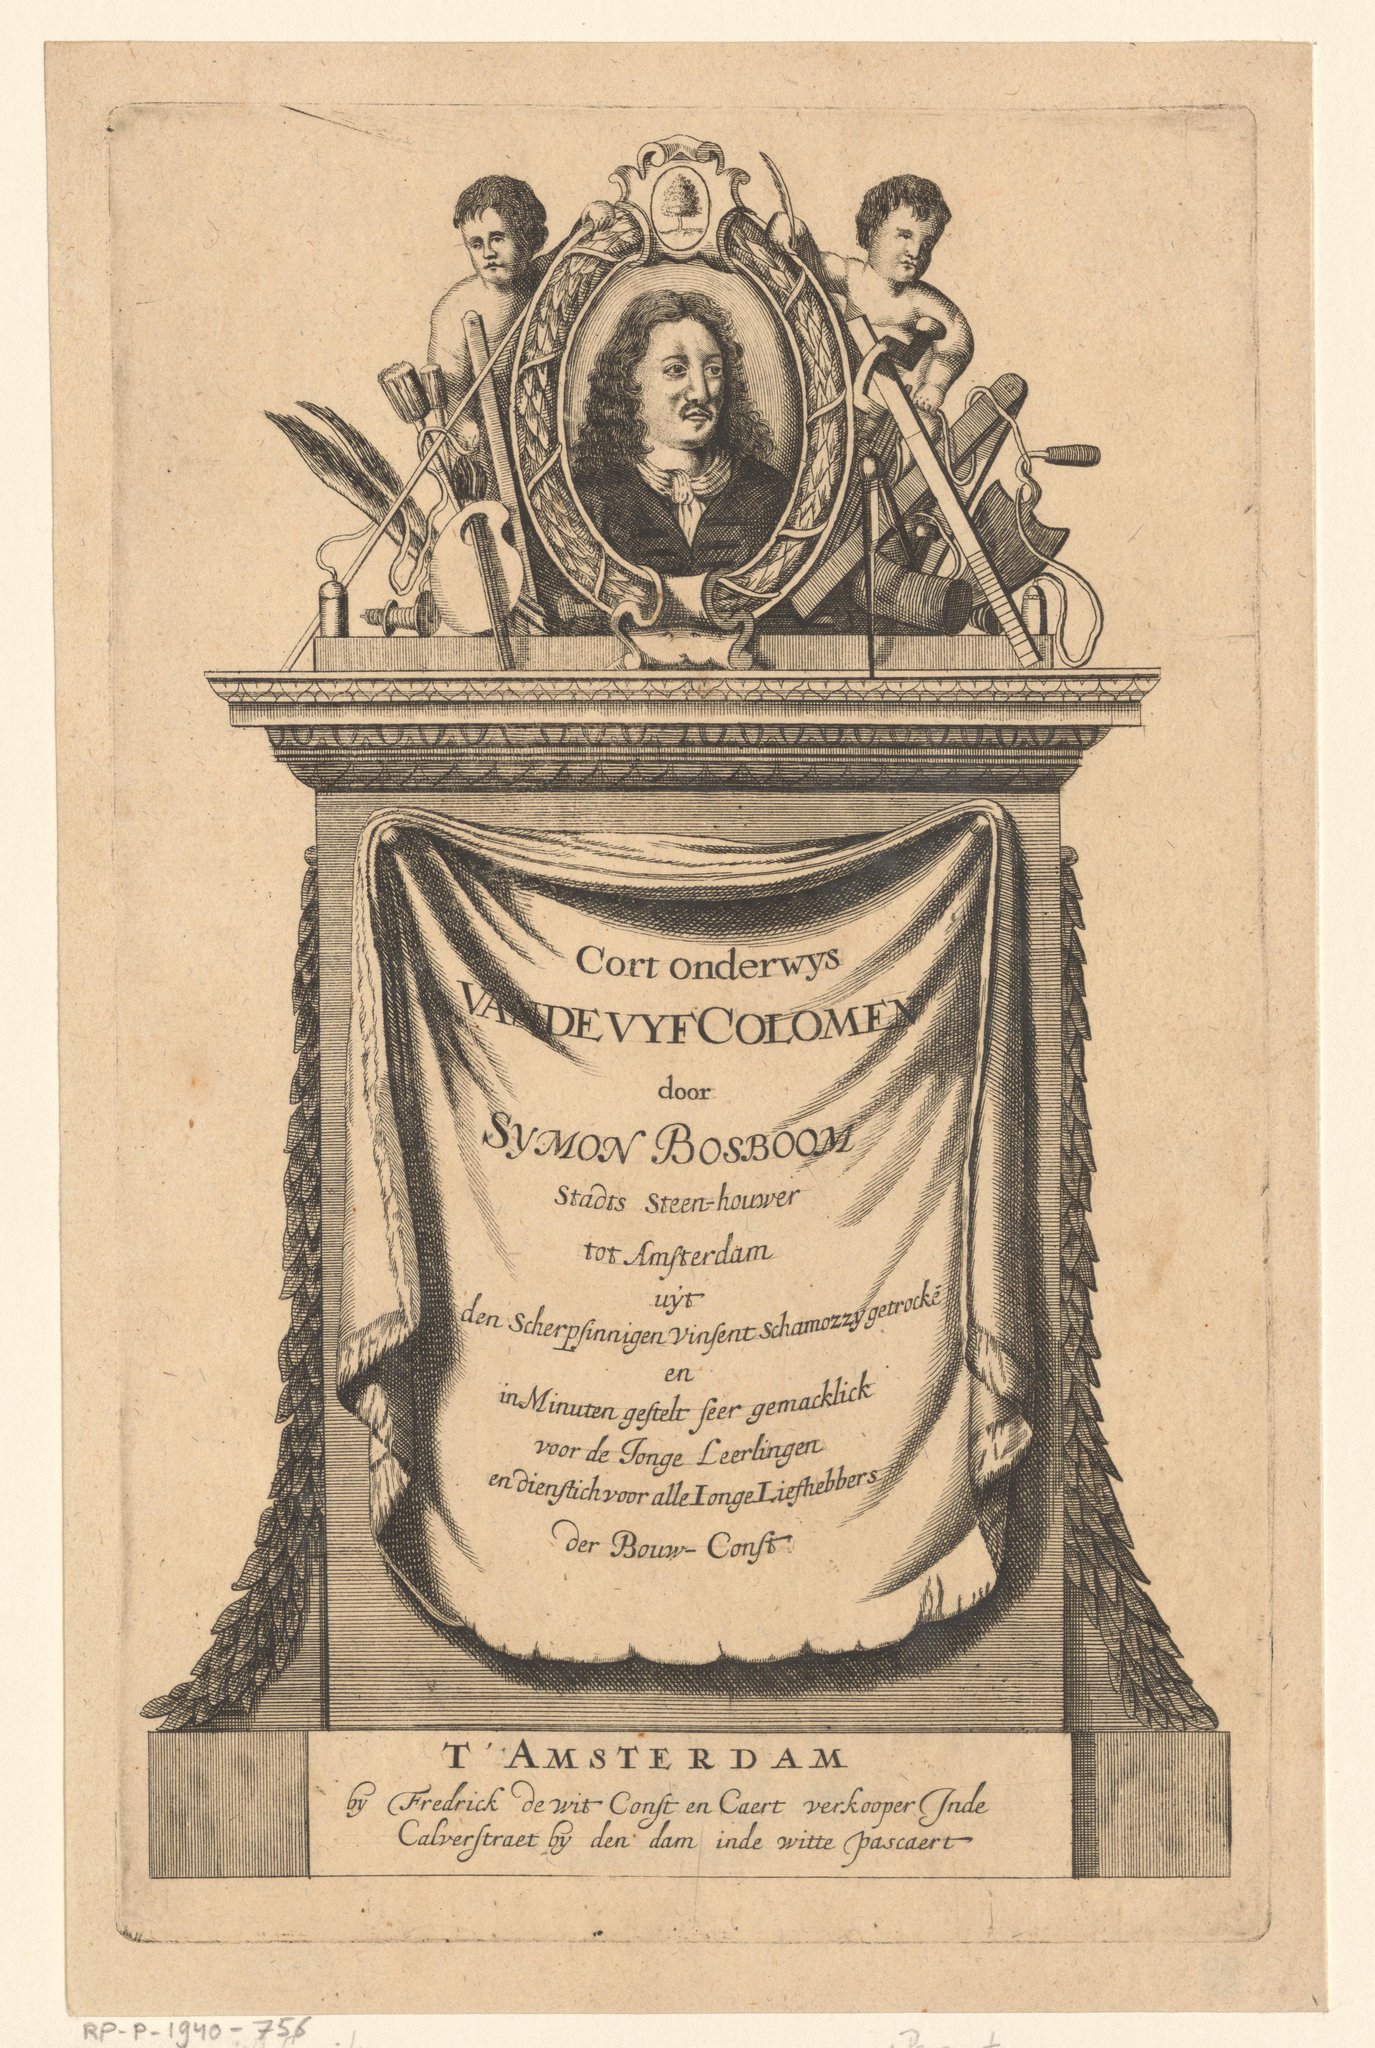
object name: print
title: Zuil met portret van Simon Bosboom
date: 1650-1699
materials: paper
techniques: engraving, etching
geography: amsterdam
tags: amsterdam, drawing-instruments, portrait, self-portrait of sculptor, historical persons, measuring-instruments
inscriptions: collector's mark: Lugt 2760, collector's mark: Lugt 2228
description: Titelpagina voor: Bosboom, Simon. Cort onderwys van de vyf colomen. Amsterdam: Frederik de Wit, s.a.